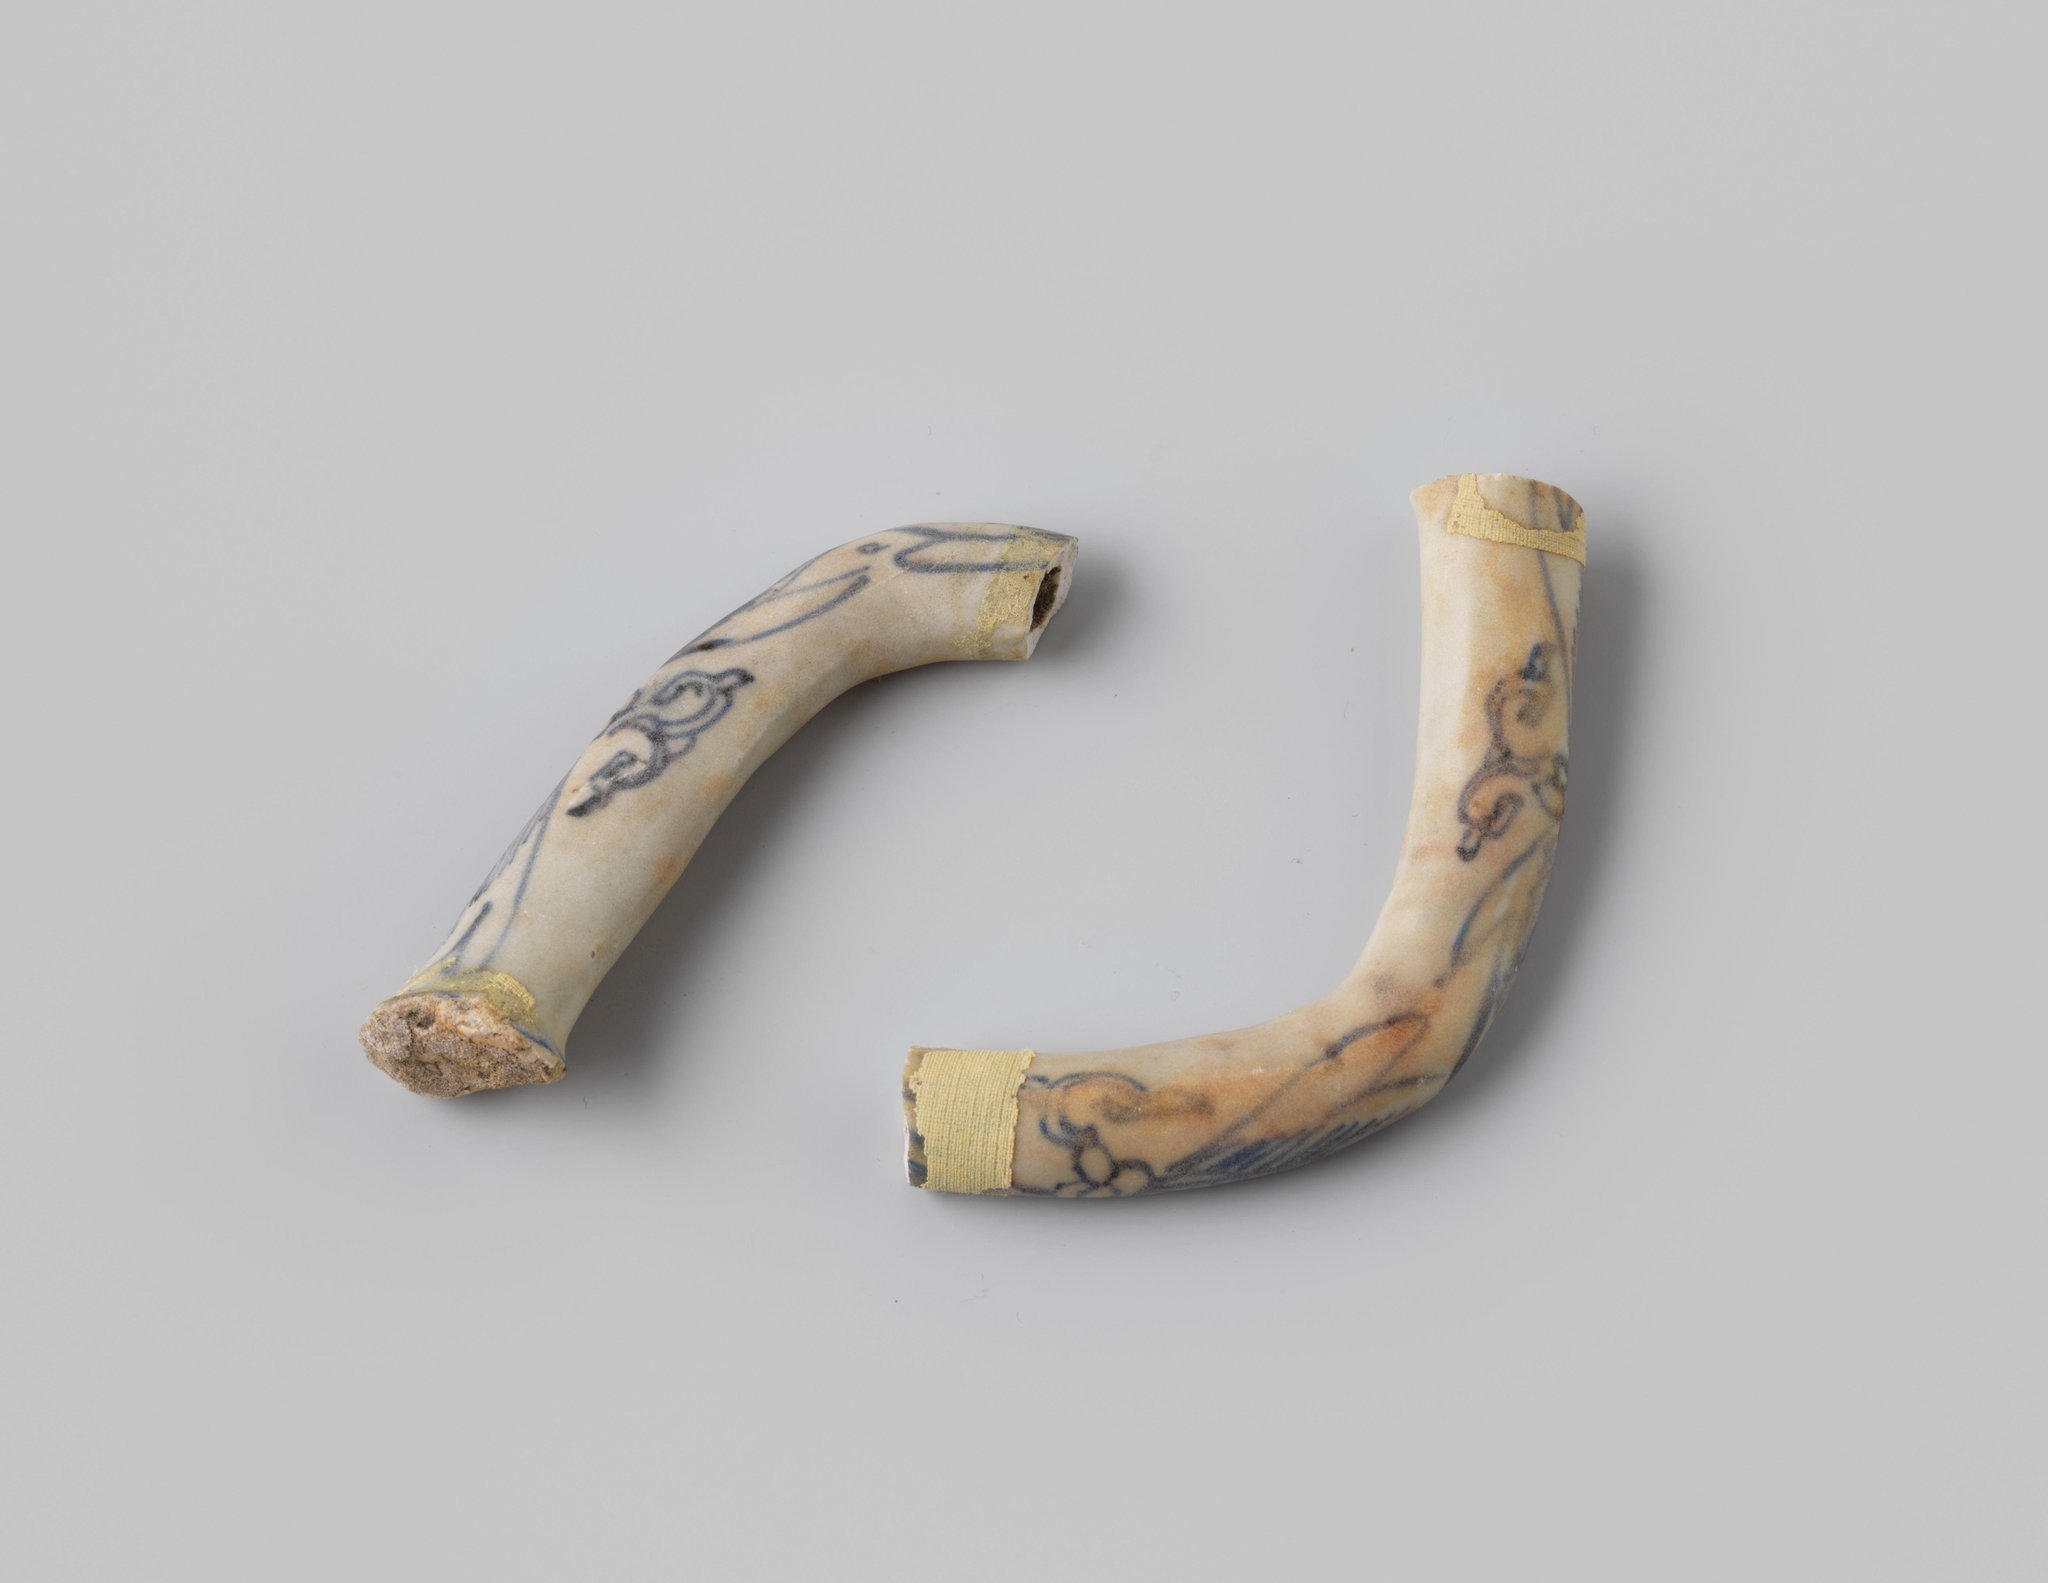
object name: teapot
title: Handvat/oor van theepot of wijnkan uit V.O.C.-schip de 'Witte Leeuw'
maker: Anonymous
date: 1613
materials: bone china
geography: jingdezhen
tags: verenigde oostindische compagnie, sint-helena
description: Winepot with a handle and spout. The panels decorated with peonies and symbols. Shoulder and cover are decorated with two cartouches with floral sprays on a fine diaper pattern. The handle is decorated with various motives: dots and flower sprays. The spout with flame motives and stylized jewels and the cover with floral sprays and cartouches on diaper pattern. The neck with two sketchy flower sprays.